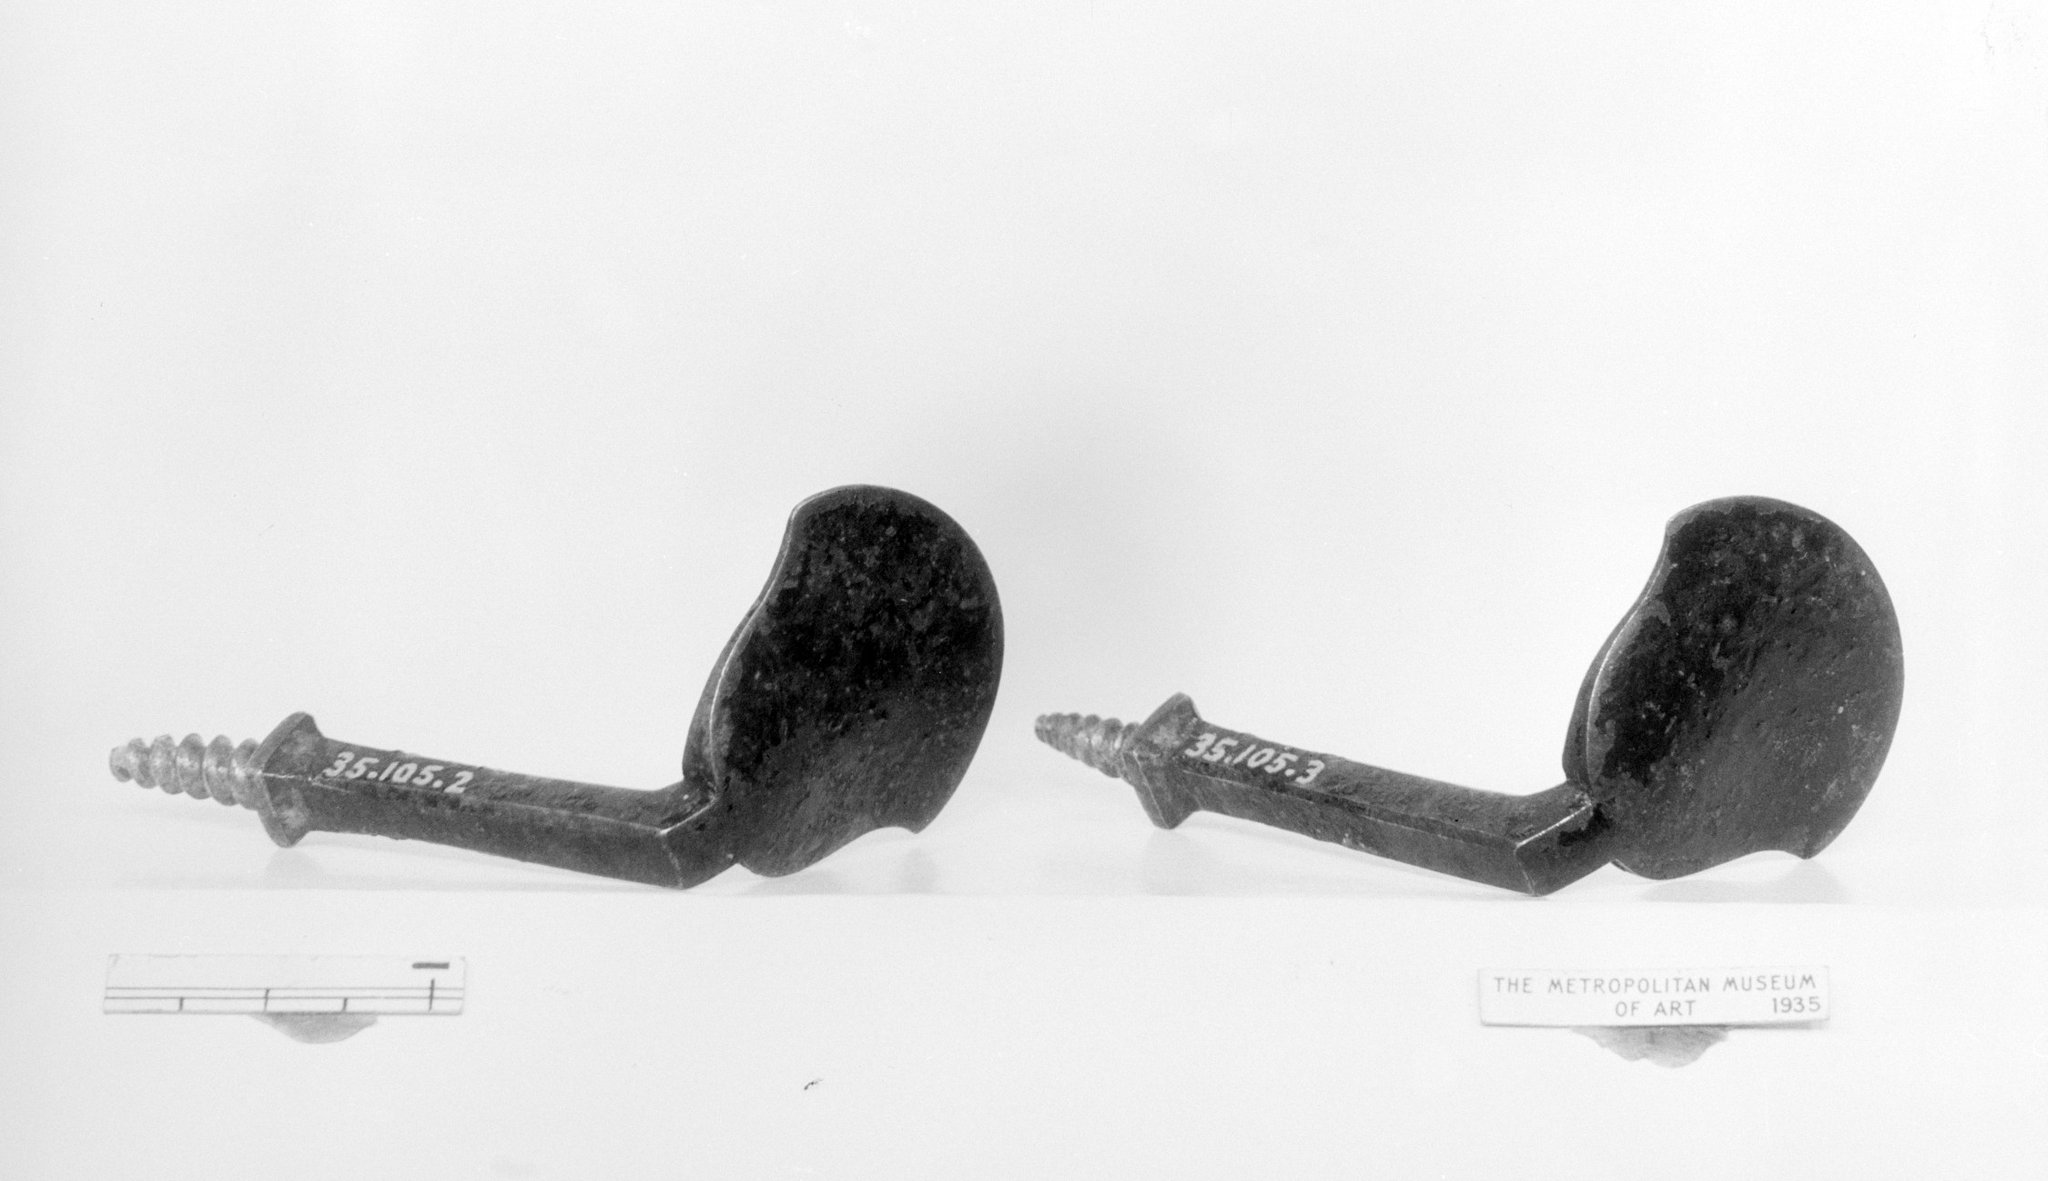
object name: gun hook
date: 1700-1800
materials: iron